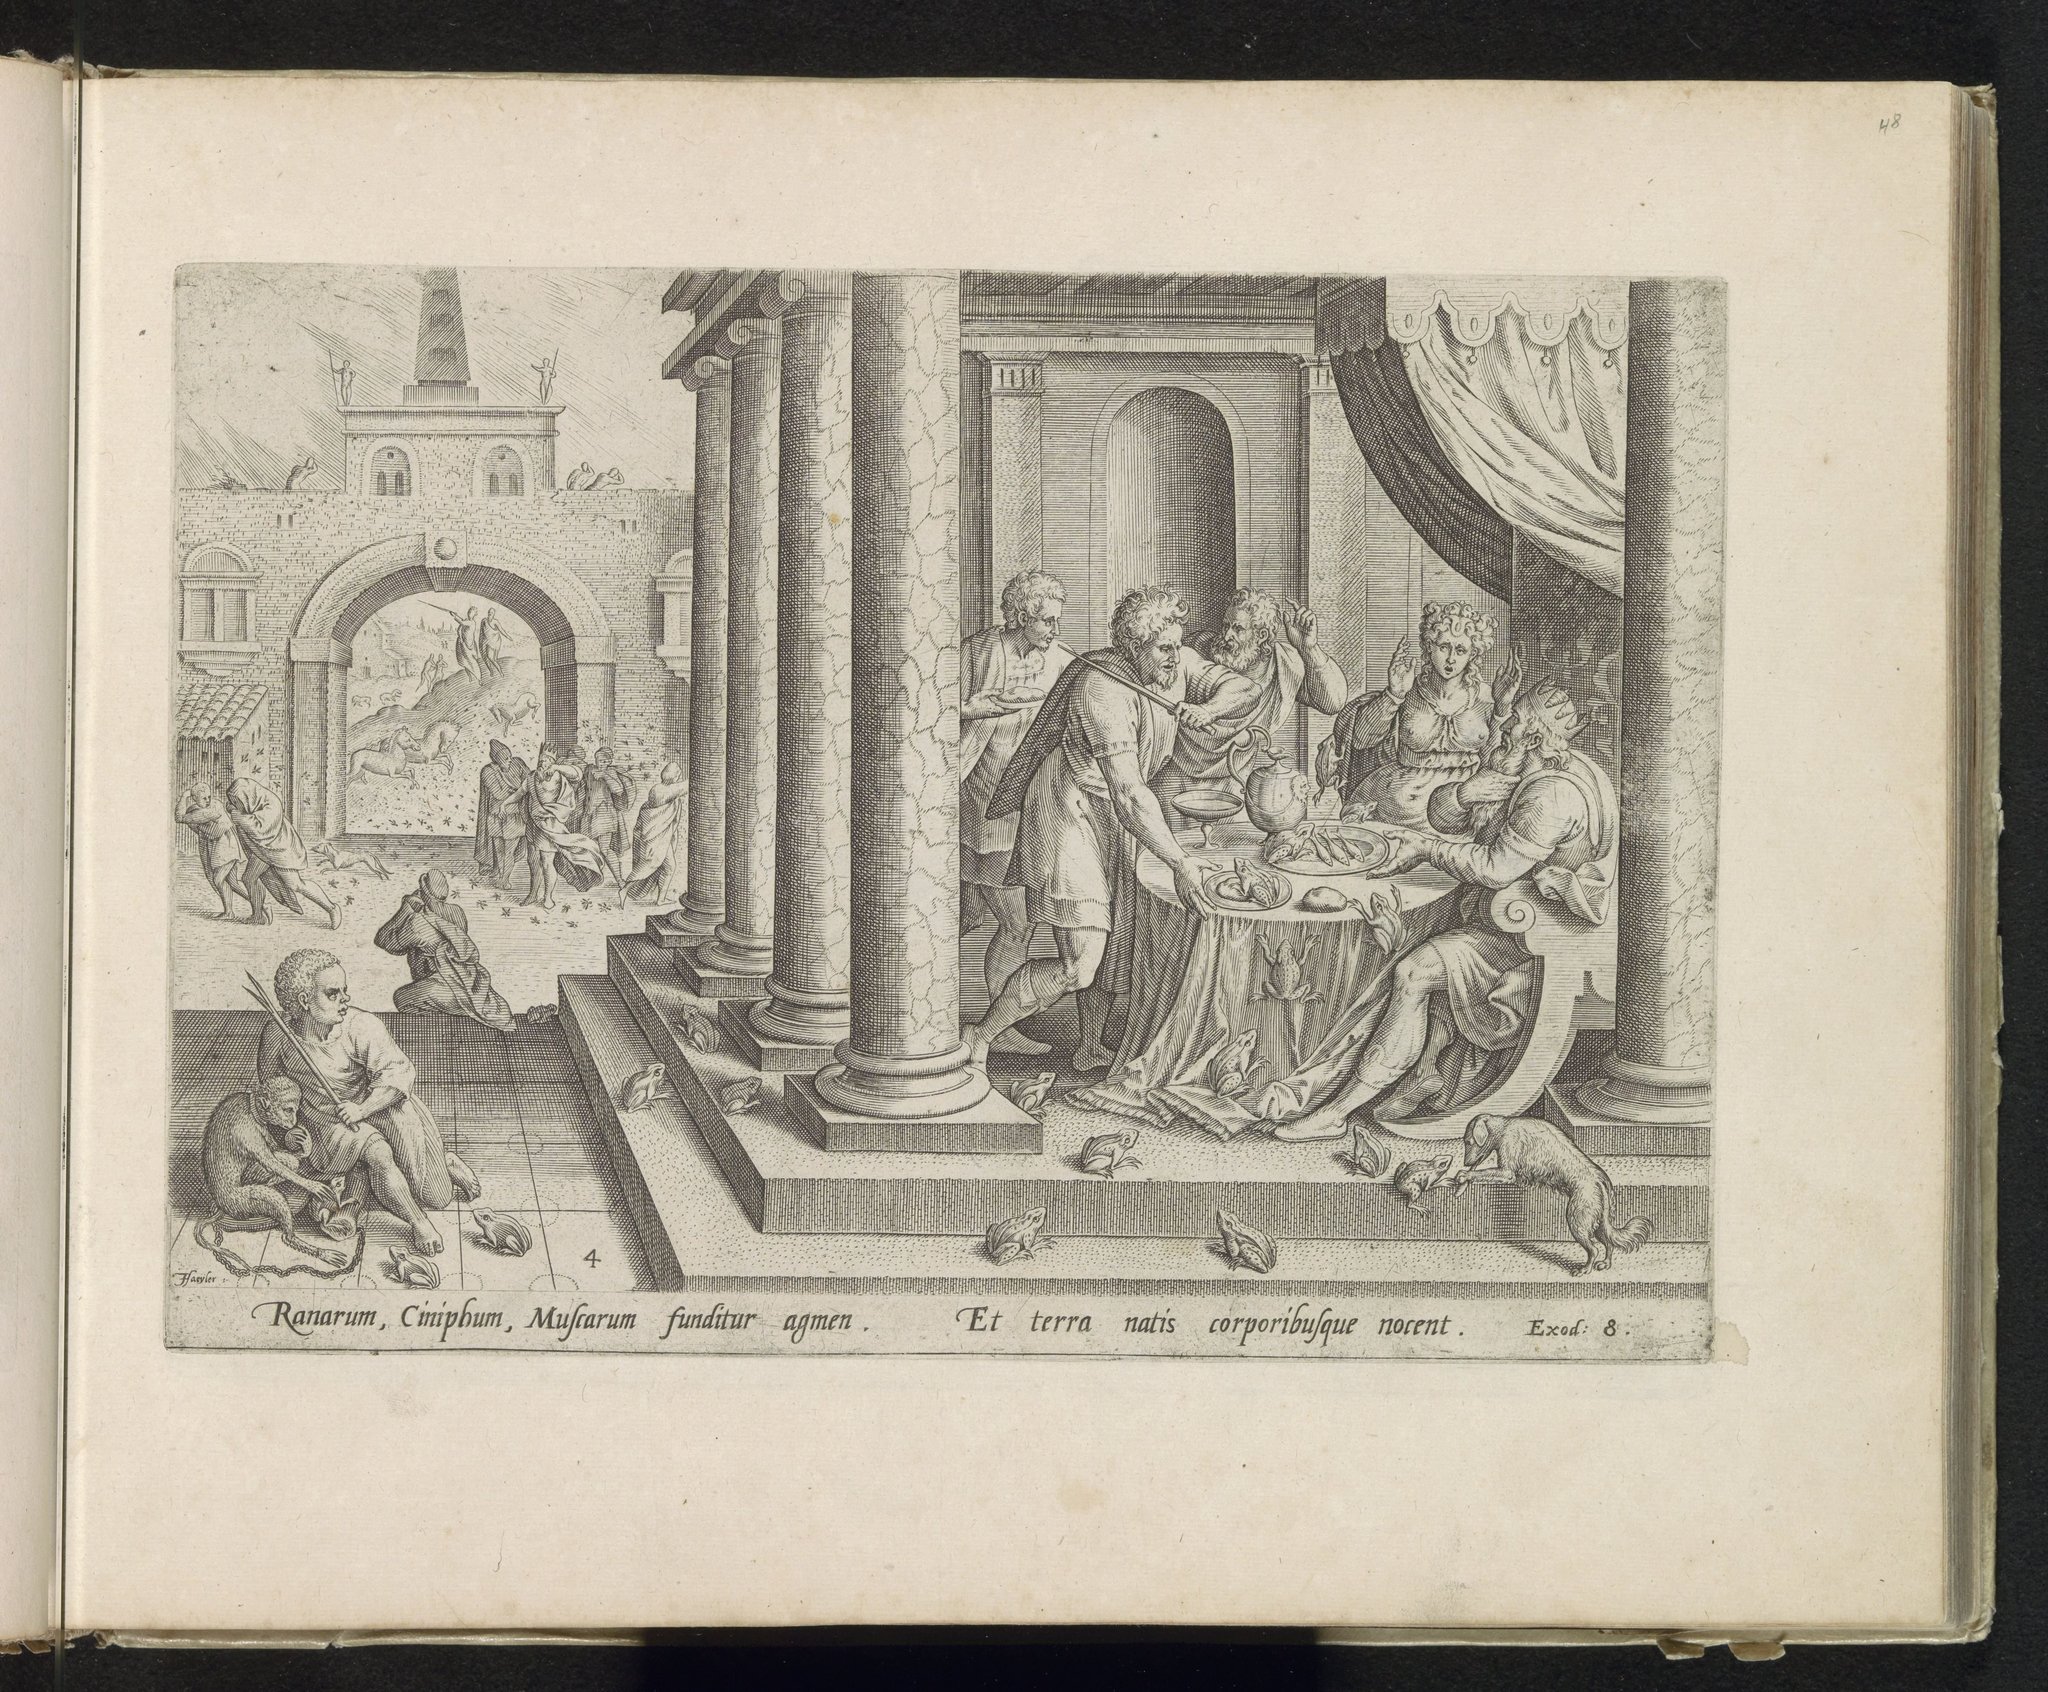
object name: album leaf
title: Thesaurus sacrarum historiaru[m] veteris testame[n]ti, elega[n]tissimis imaginibus expressu[m] excelle[n]tissimoru[m] in hac arte viroru[m] opera: nu[n]c primu[m] in luce[m] editus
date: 1585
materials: paper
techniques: engraving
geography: antwerp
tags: the plague of frogs: aaron stretches out his hand over the water of egypt; frogs come out and cover the land, the plague of lice: aaron strikes the ground with his rod and the dust turns into lice, the plague of flies which fill the houses of the egyptians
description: Op de voorgrond de tweede plaag die God over Egypte liet komen: een kikkerplaag. Een groep mensen zit aan tafel met rondom overal kikkers. Op de achtergrond wordt de farao aangevallen door muggen en steekvliegen. Op de achtergrond Aäron met zijn staf en Mozes. Onder de voorstelling een verwijzing in het Latijn naar de Bijbeltekst in Ex. 8. Deze prent maakt deel uit van een album.